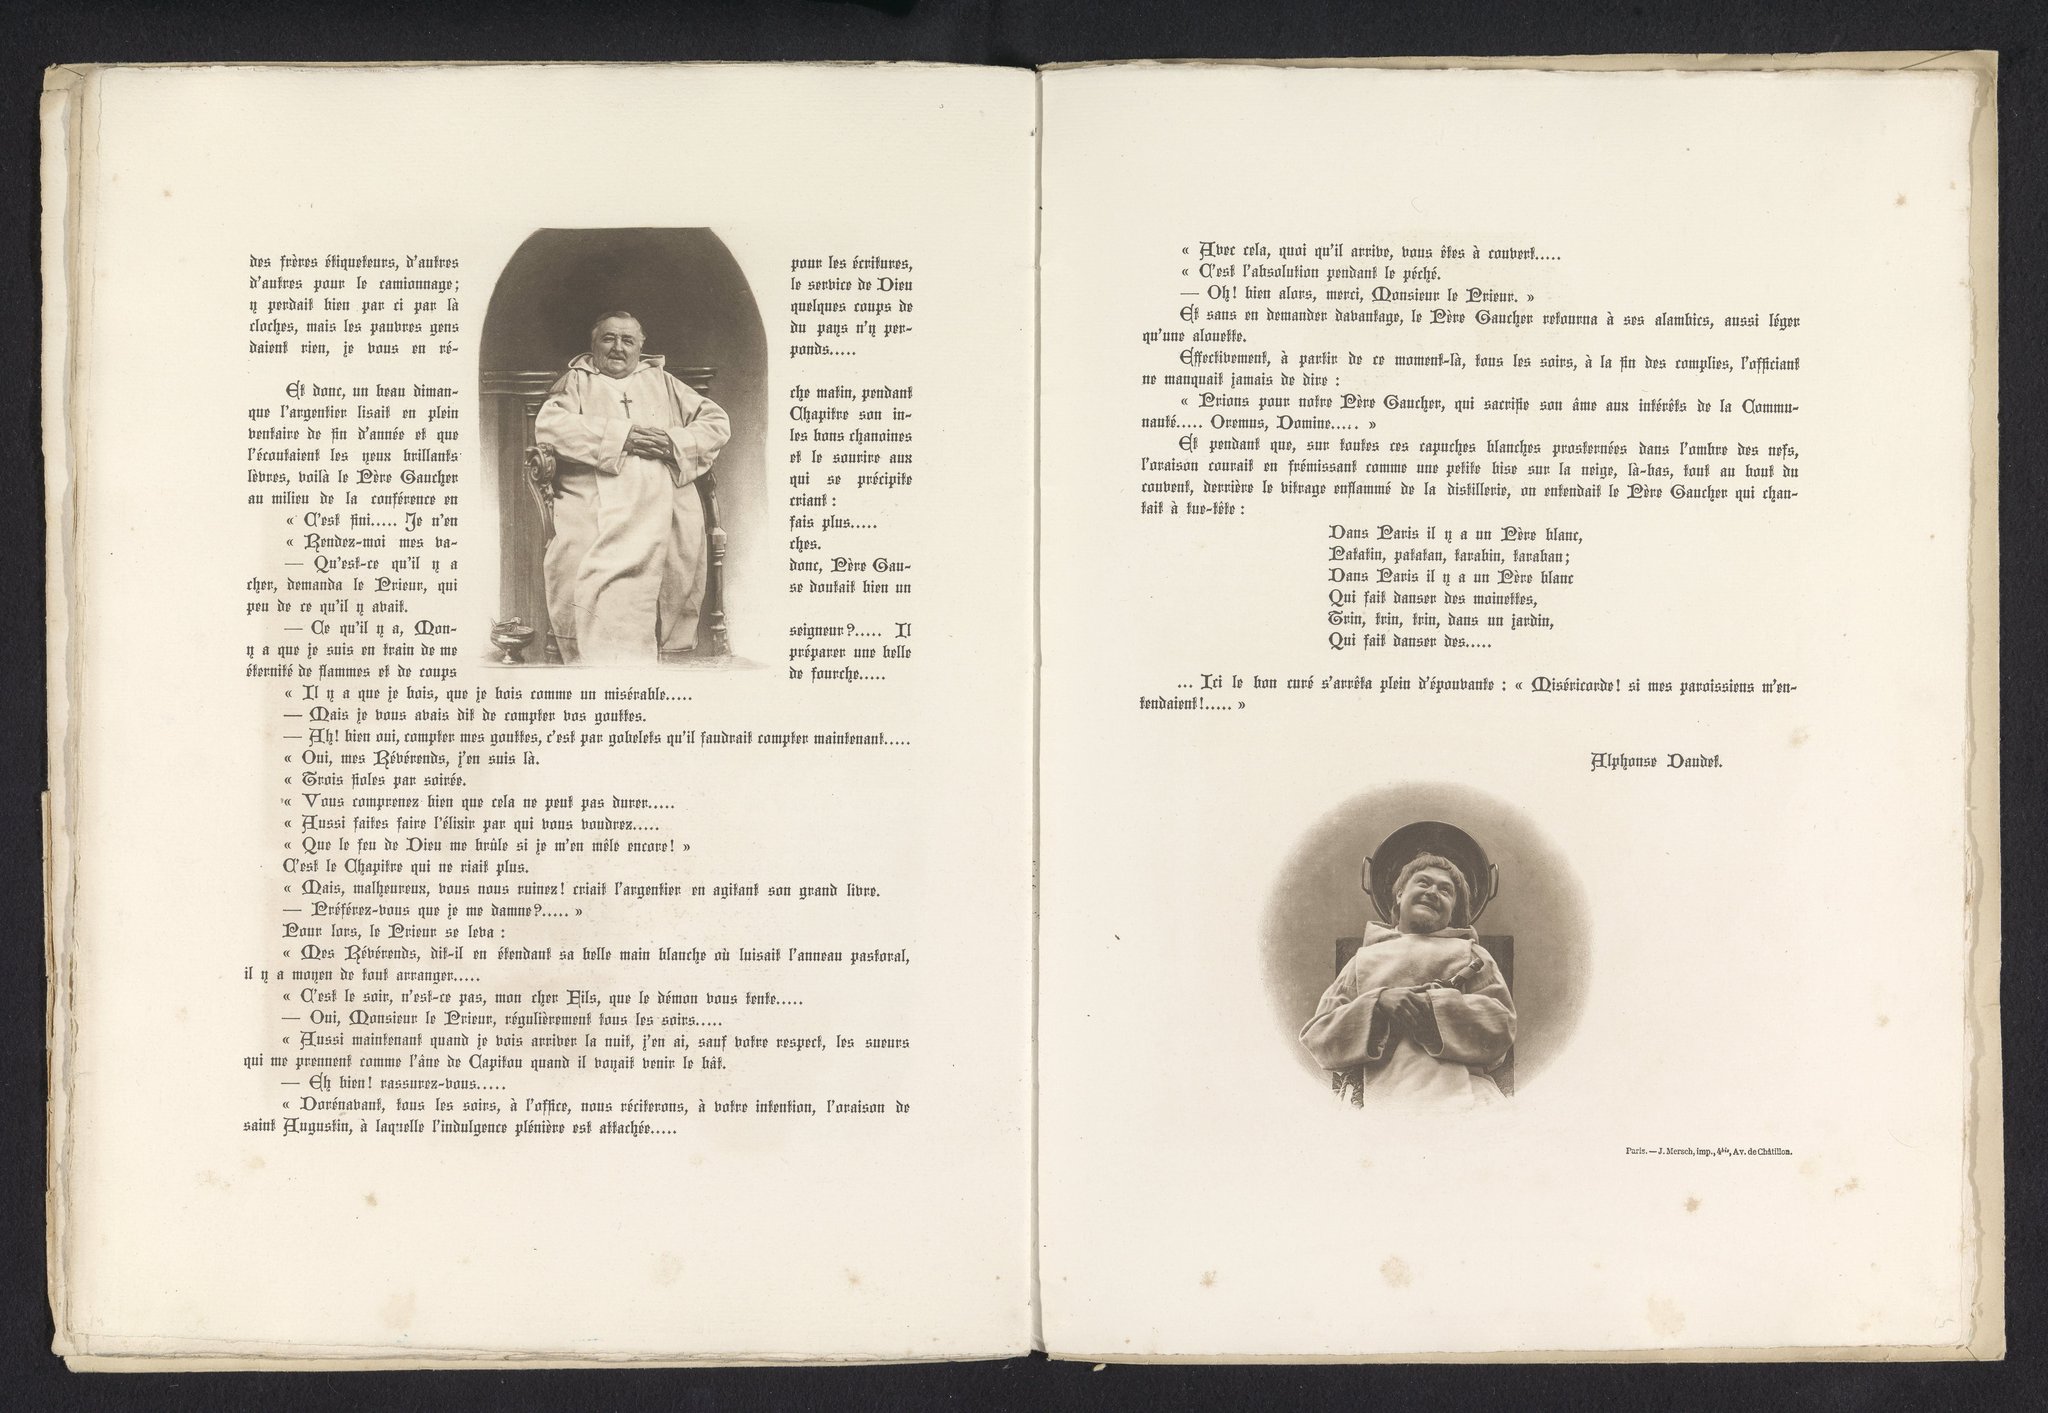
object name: page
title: Lachende monnik met een fles in de hand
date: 1885-1896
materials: paper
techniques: photoaquatint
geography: france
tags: smiling, monk(s), friar(s), bottling of wine